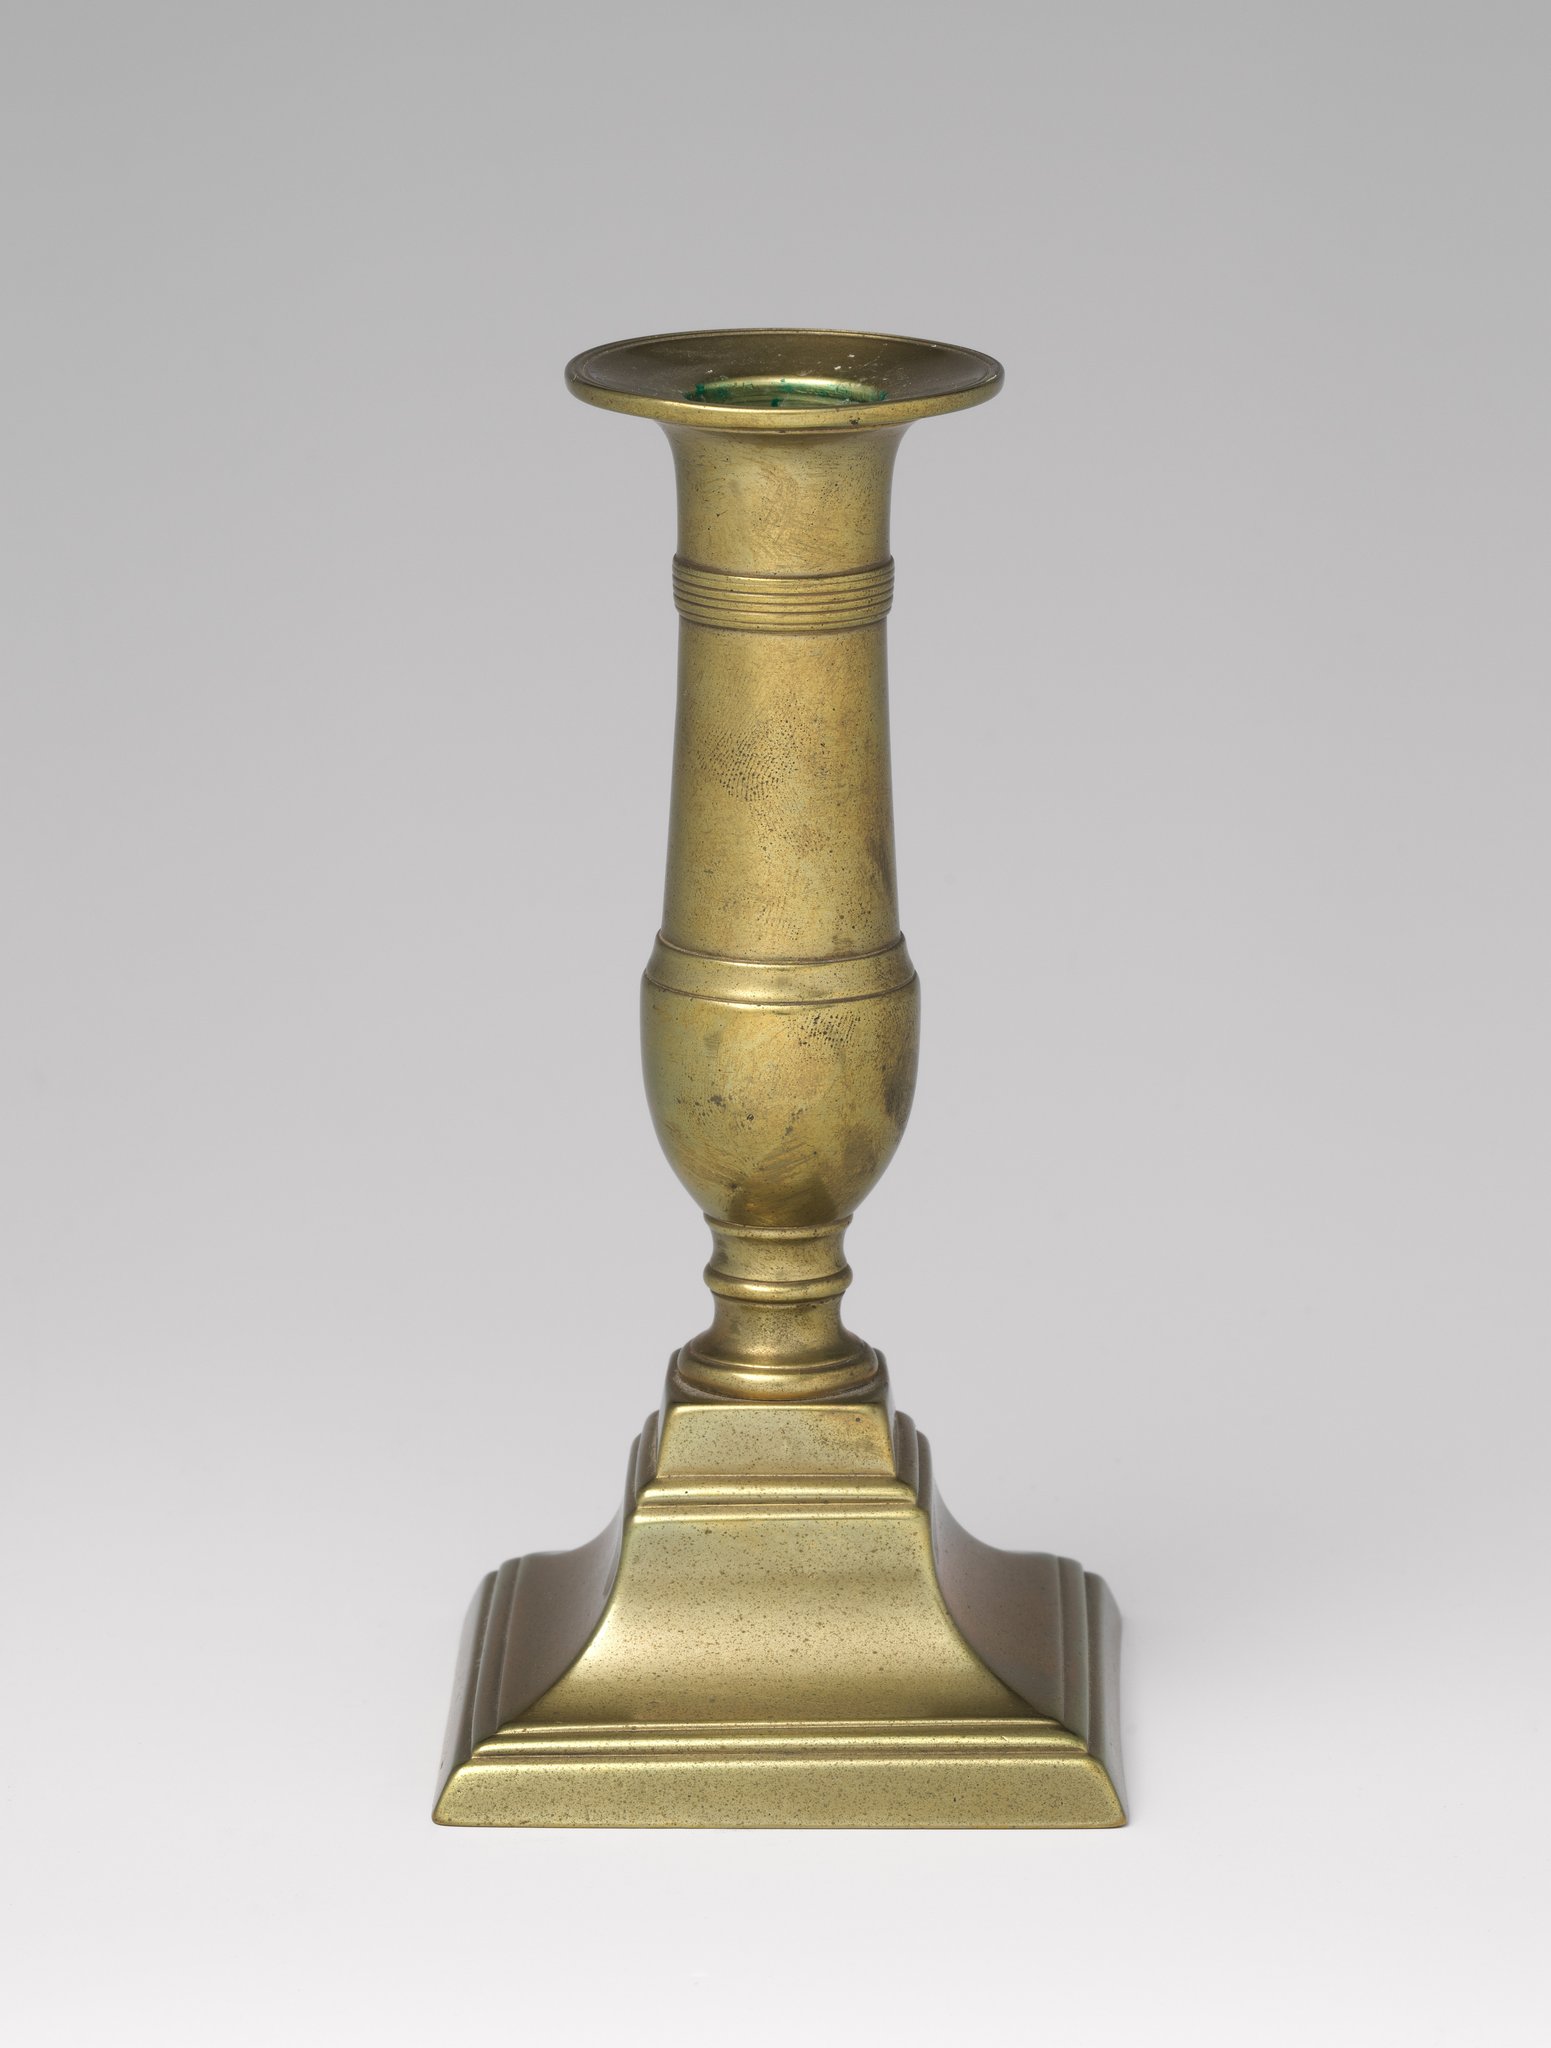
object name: candlestick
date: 1700-1800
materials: brass